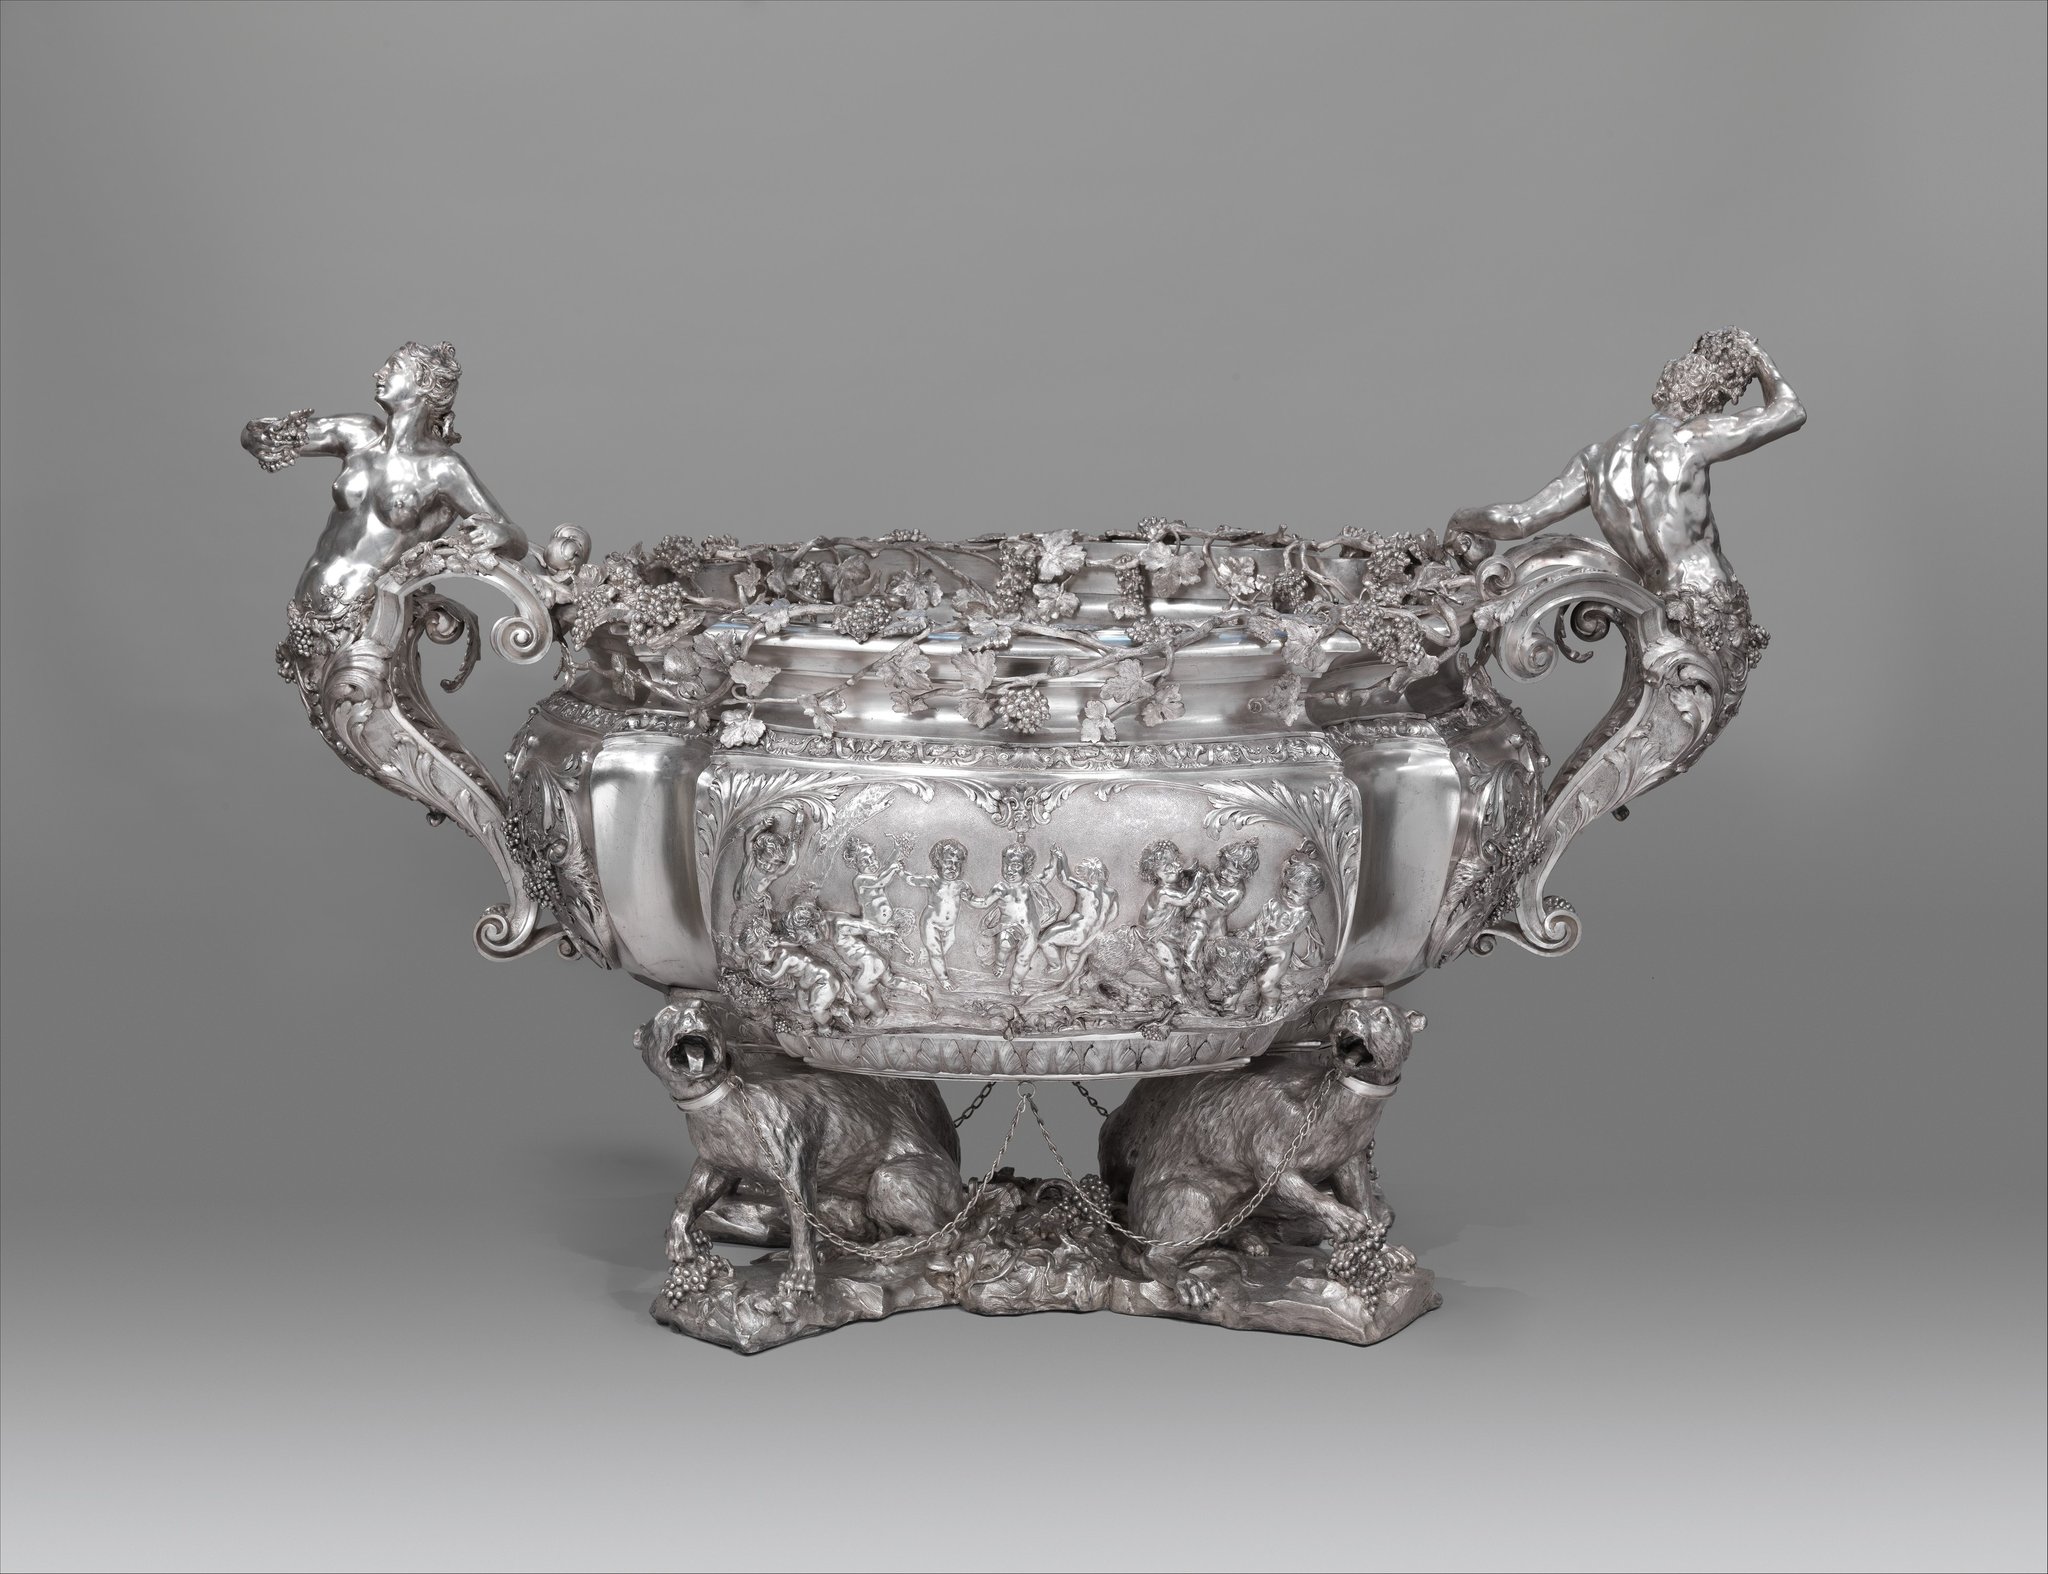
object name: wine cistern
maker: charles frederich kandler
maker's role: maker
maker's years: 1678-1778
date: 1880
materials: metal, silver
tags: animals,infants,women